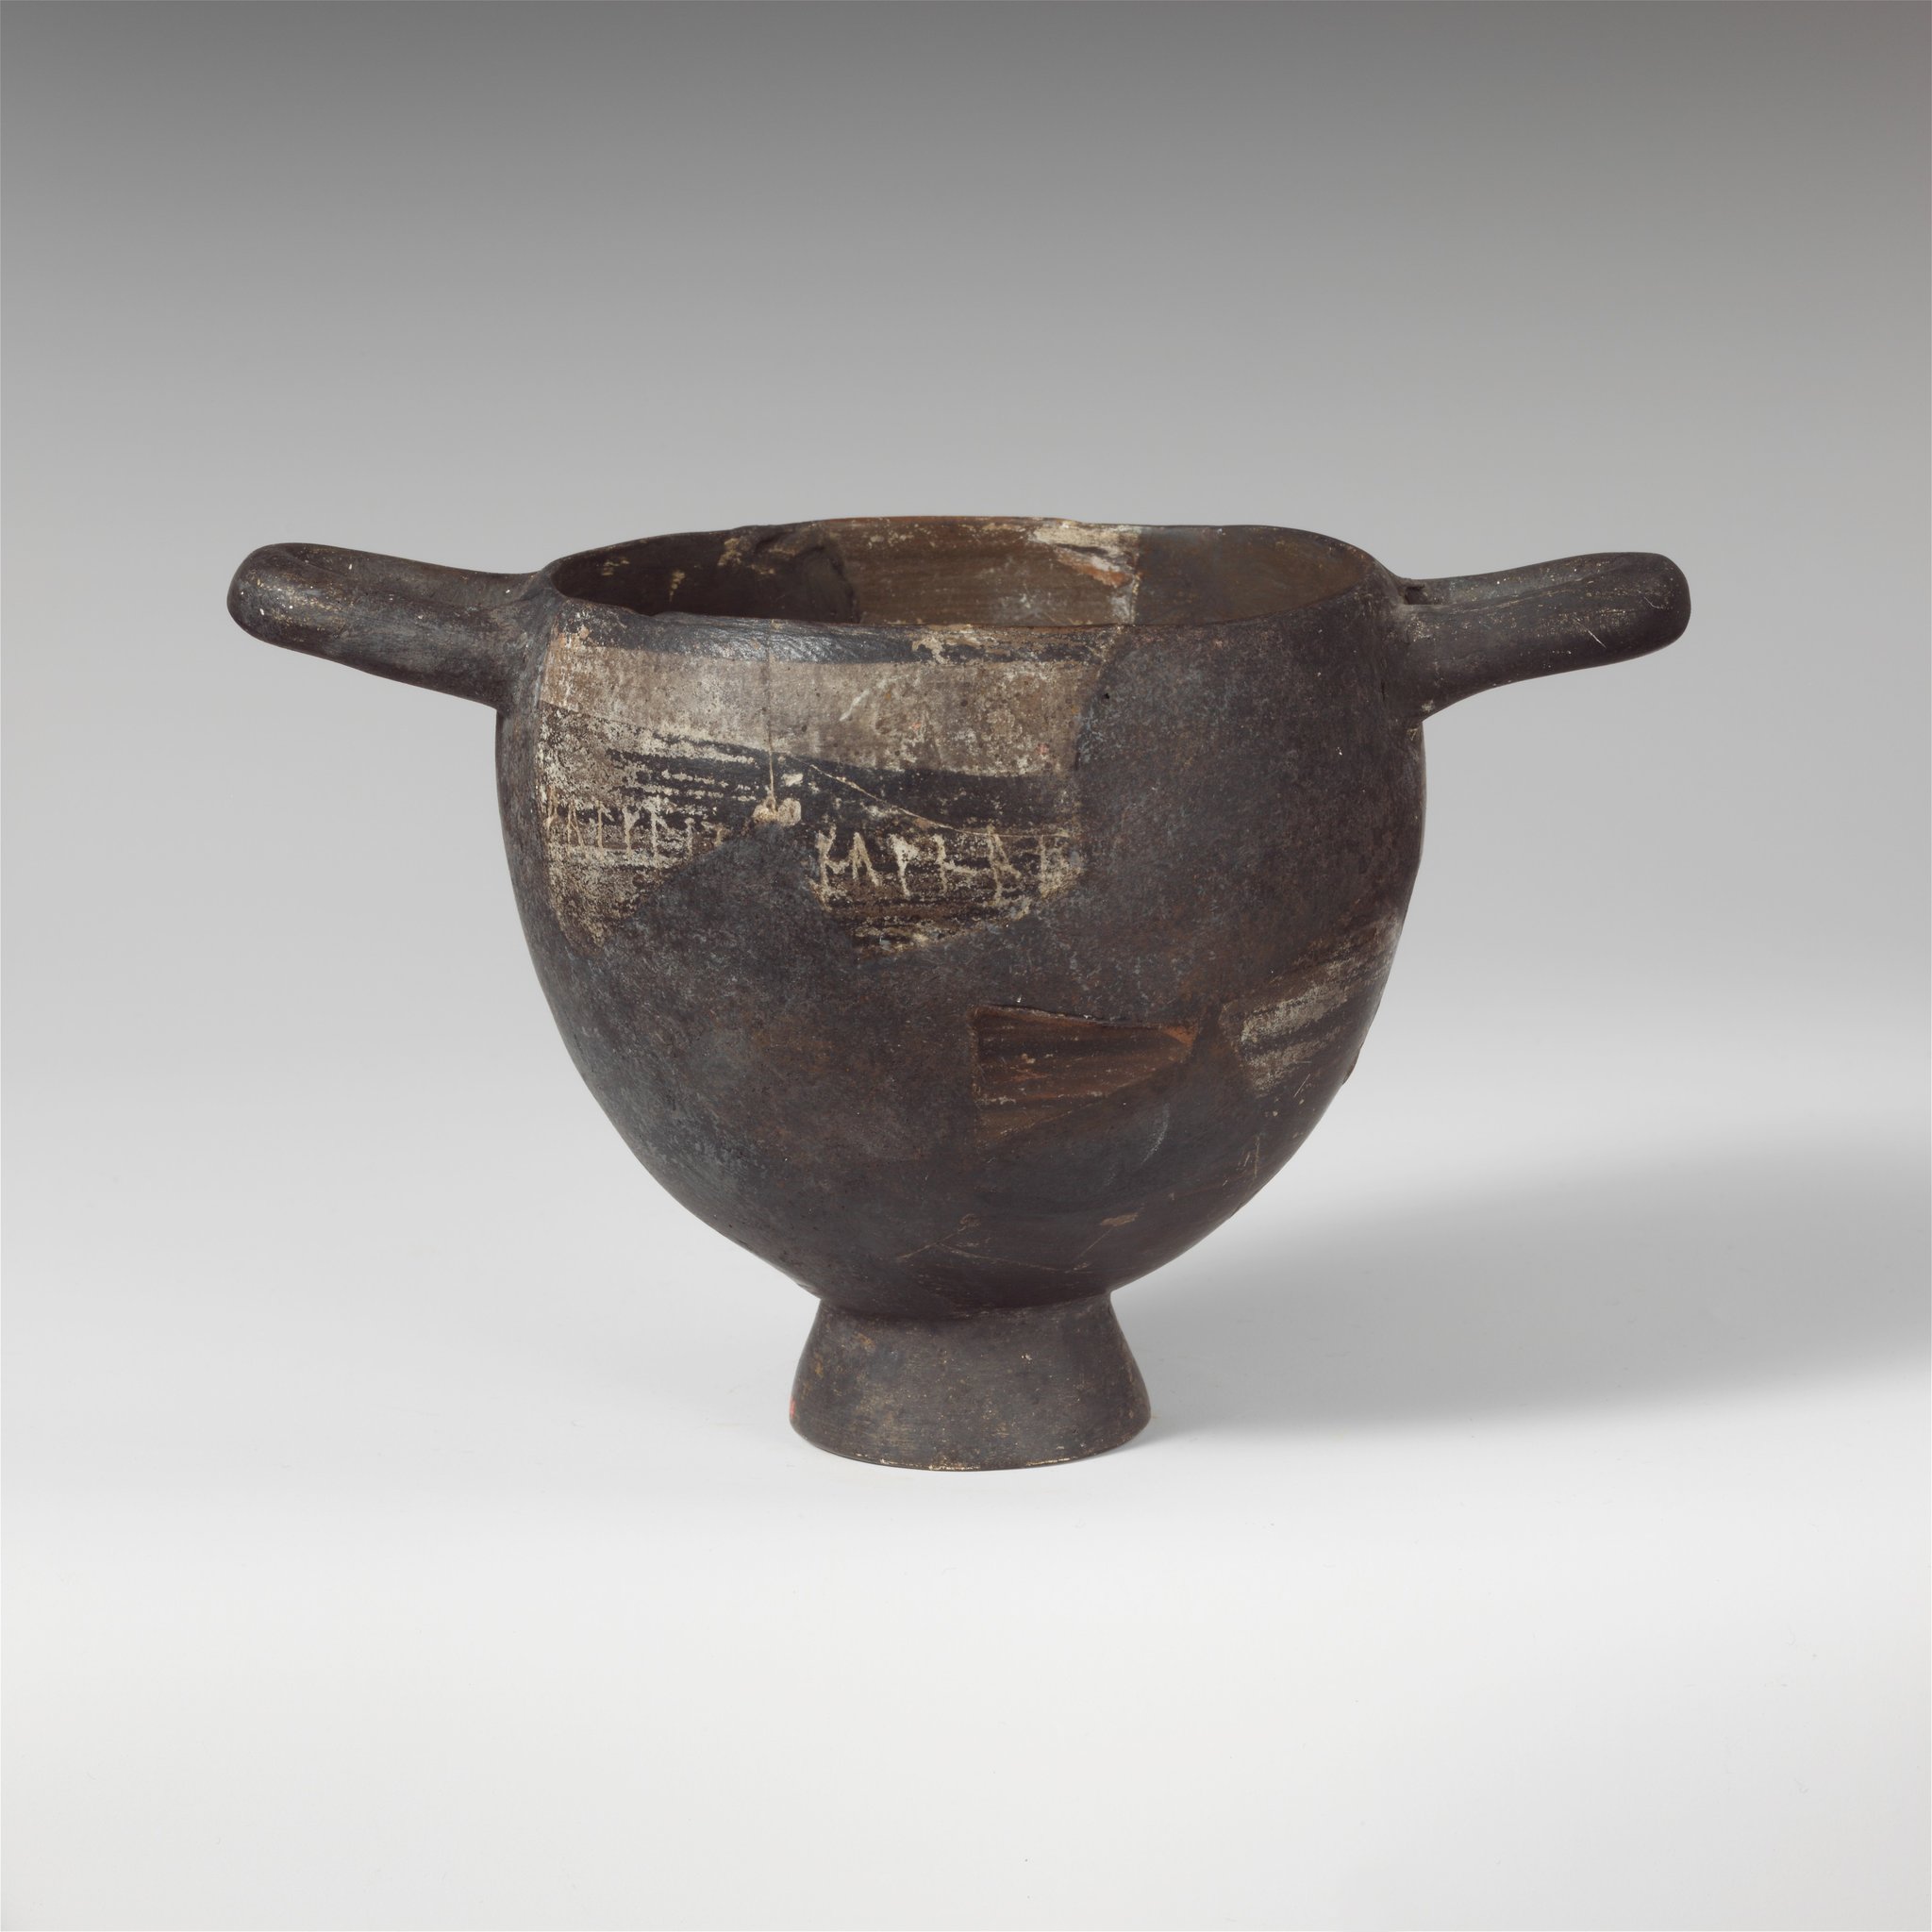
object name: skyphos, fragmentary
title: Fragment of a terracotta skyphos (deep drinking cup)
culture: lydian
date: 600-401 BCE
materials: terracotta